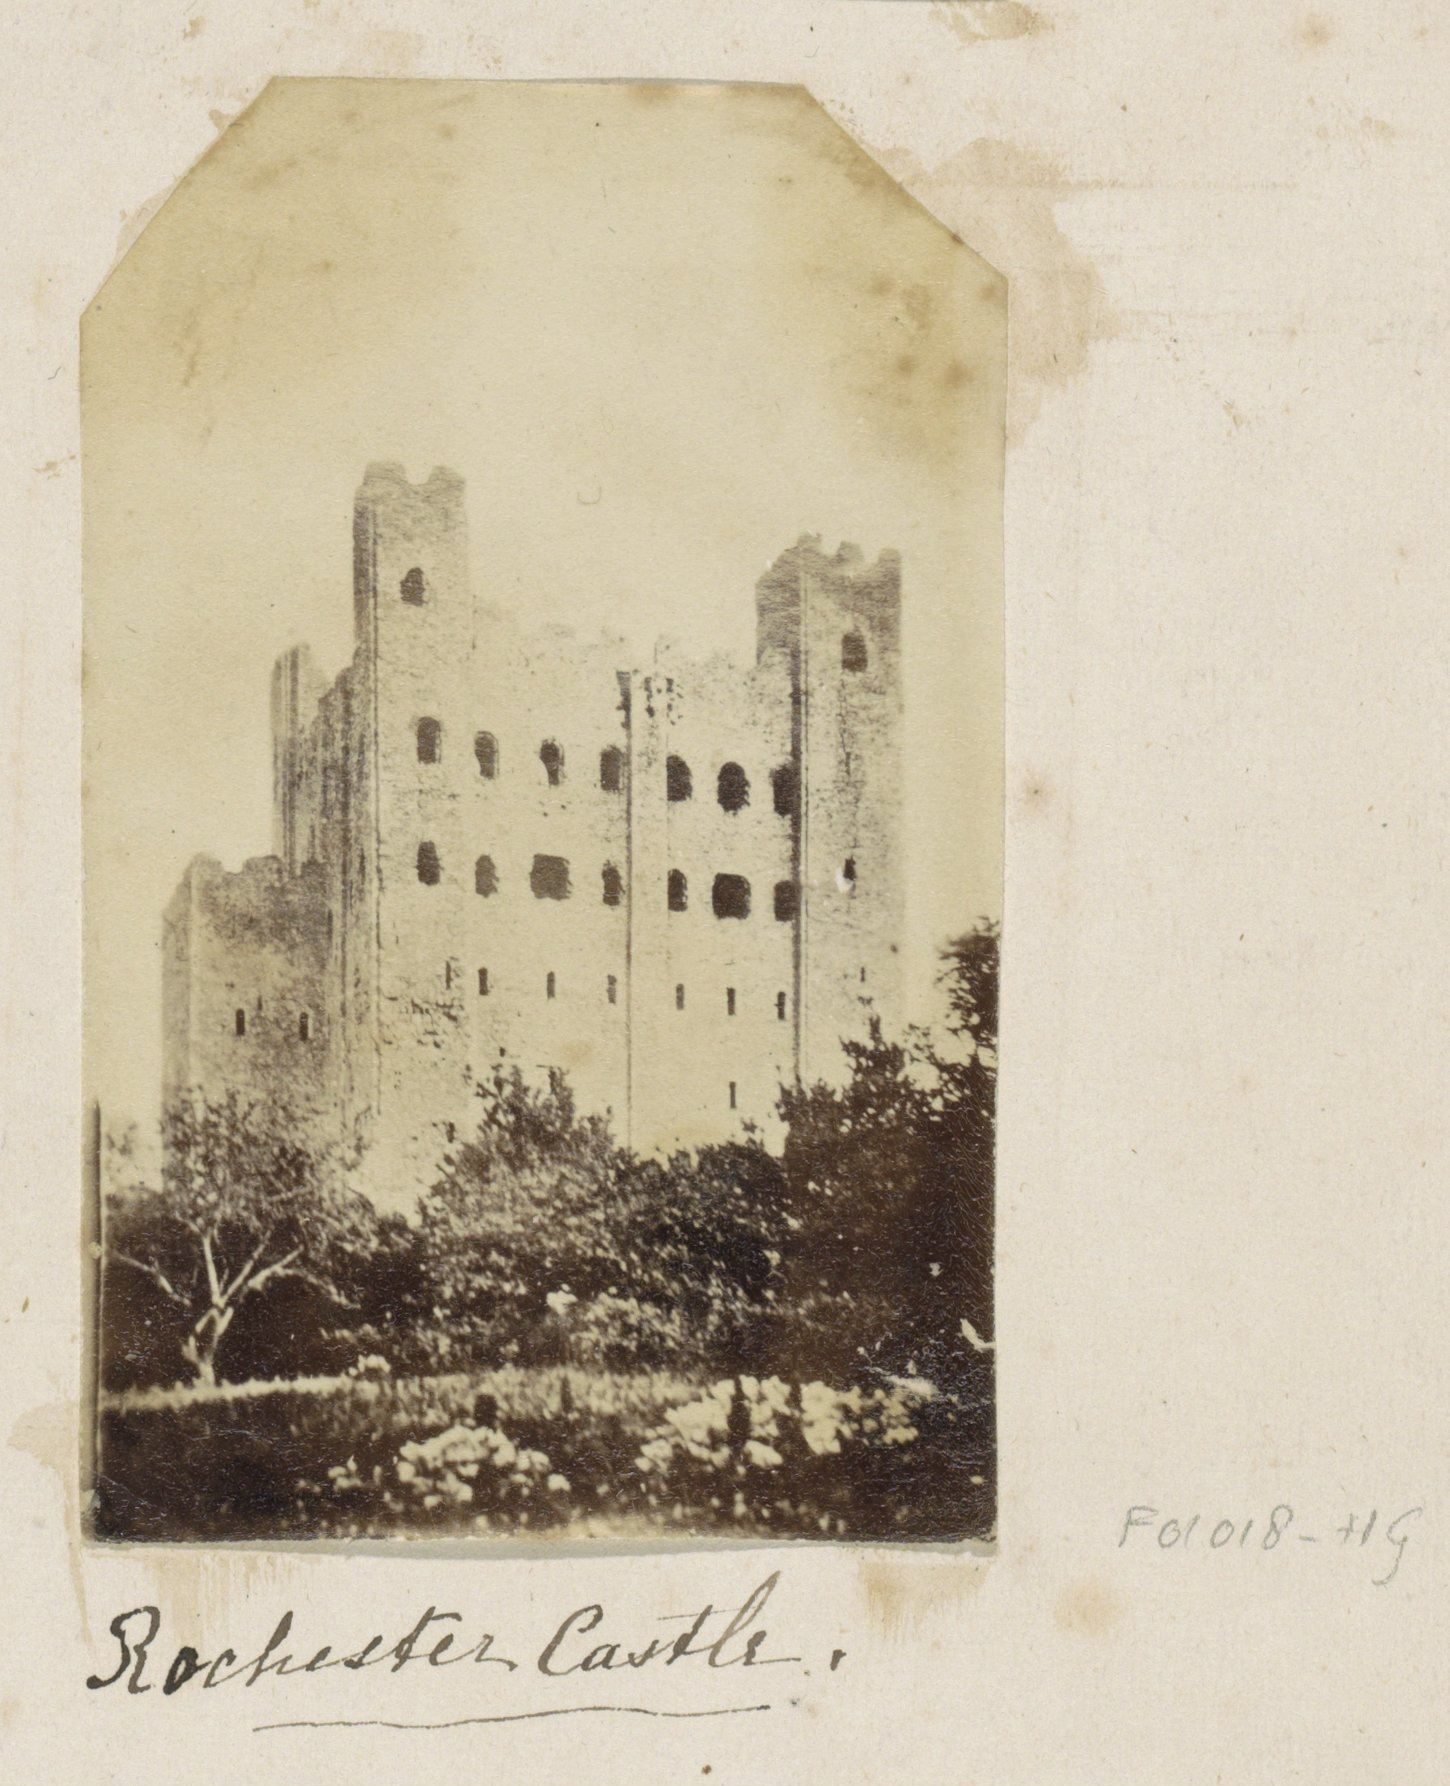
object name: photograph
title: Rochester Castle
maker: Anonymous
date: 1860-1870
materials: paper, photographic support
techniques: albumen print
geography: rochester castle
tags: castle, ruin of a dwelling, house, castle, etc.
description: Onderdeel van Engels familiealbum met foto's van personen, reizen, cricket en kunstwerken.